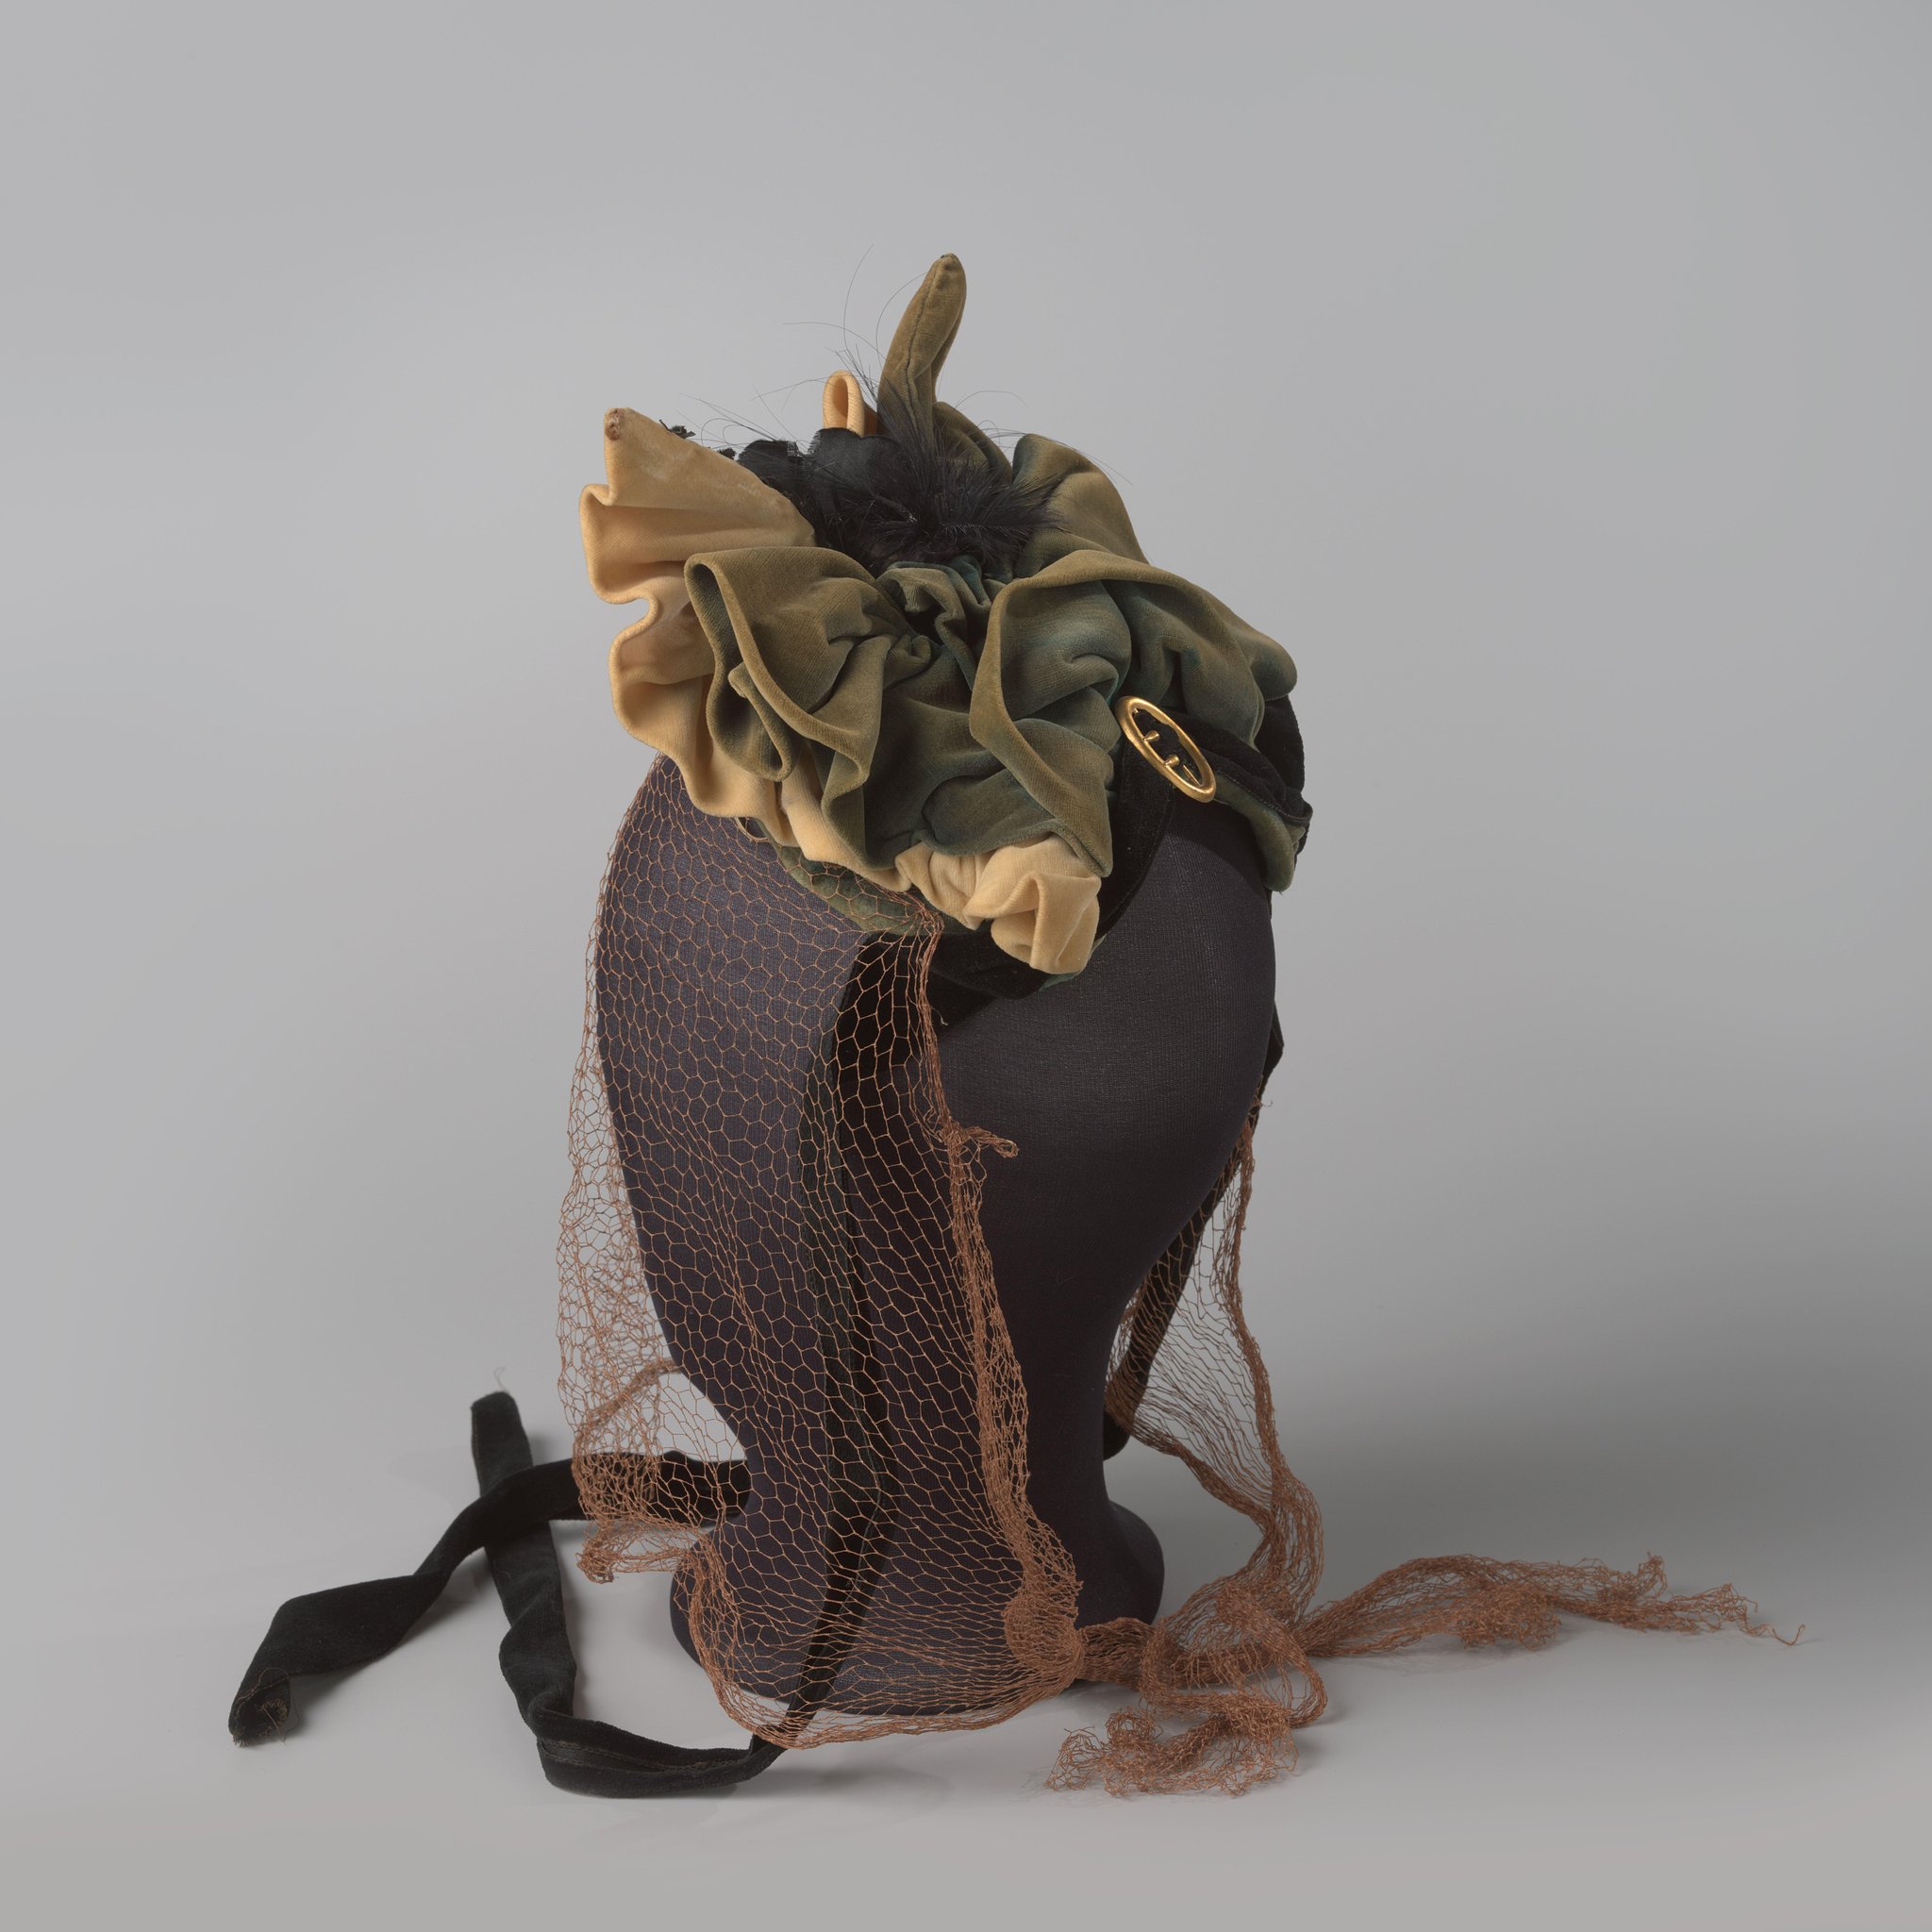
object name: womenswear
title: Hoed, zogenaamd kapothoedje van groen en wit fluweel met zwart bandfluweel en corsage alsmede een aigrette en koperen gesp, bruine voile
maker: Anonymous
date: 1885-1895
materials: copper, feather, velvet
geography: netherlands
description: Kapothoedje van groen en wit fluweel en zwart bandfluweel. Zwarte corsage, zwart kant met chenille-draad. Kleine zwarte aigrette, koperen gespje, bruine voile. Voor op hoofd te dragen hoedje met rudimentaire klep aan een beugel van metalen draadvulling, bekleed met fluweel. De breed uitstaande strik loopt over in de kokarde van fluweel. Middenvoor een klein fluwelen strikje met een corsage.